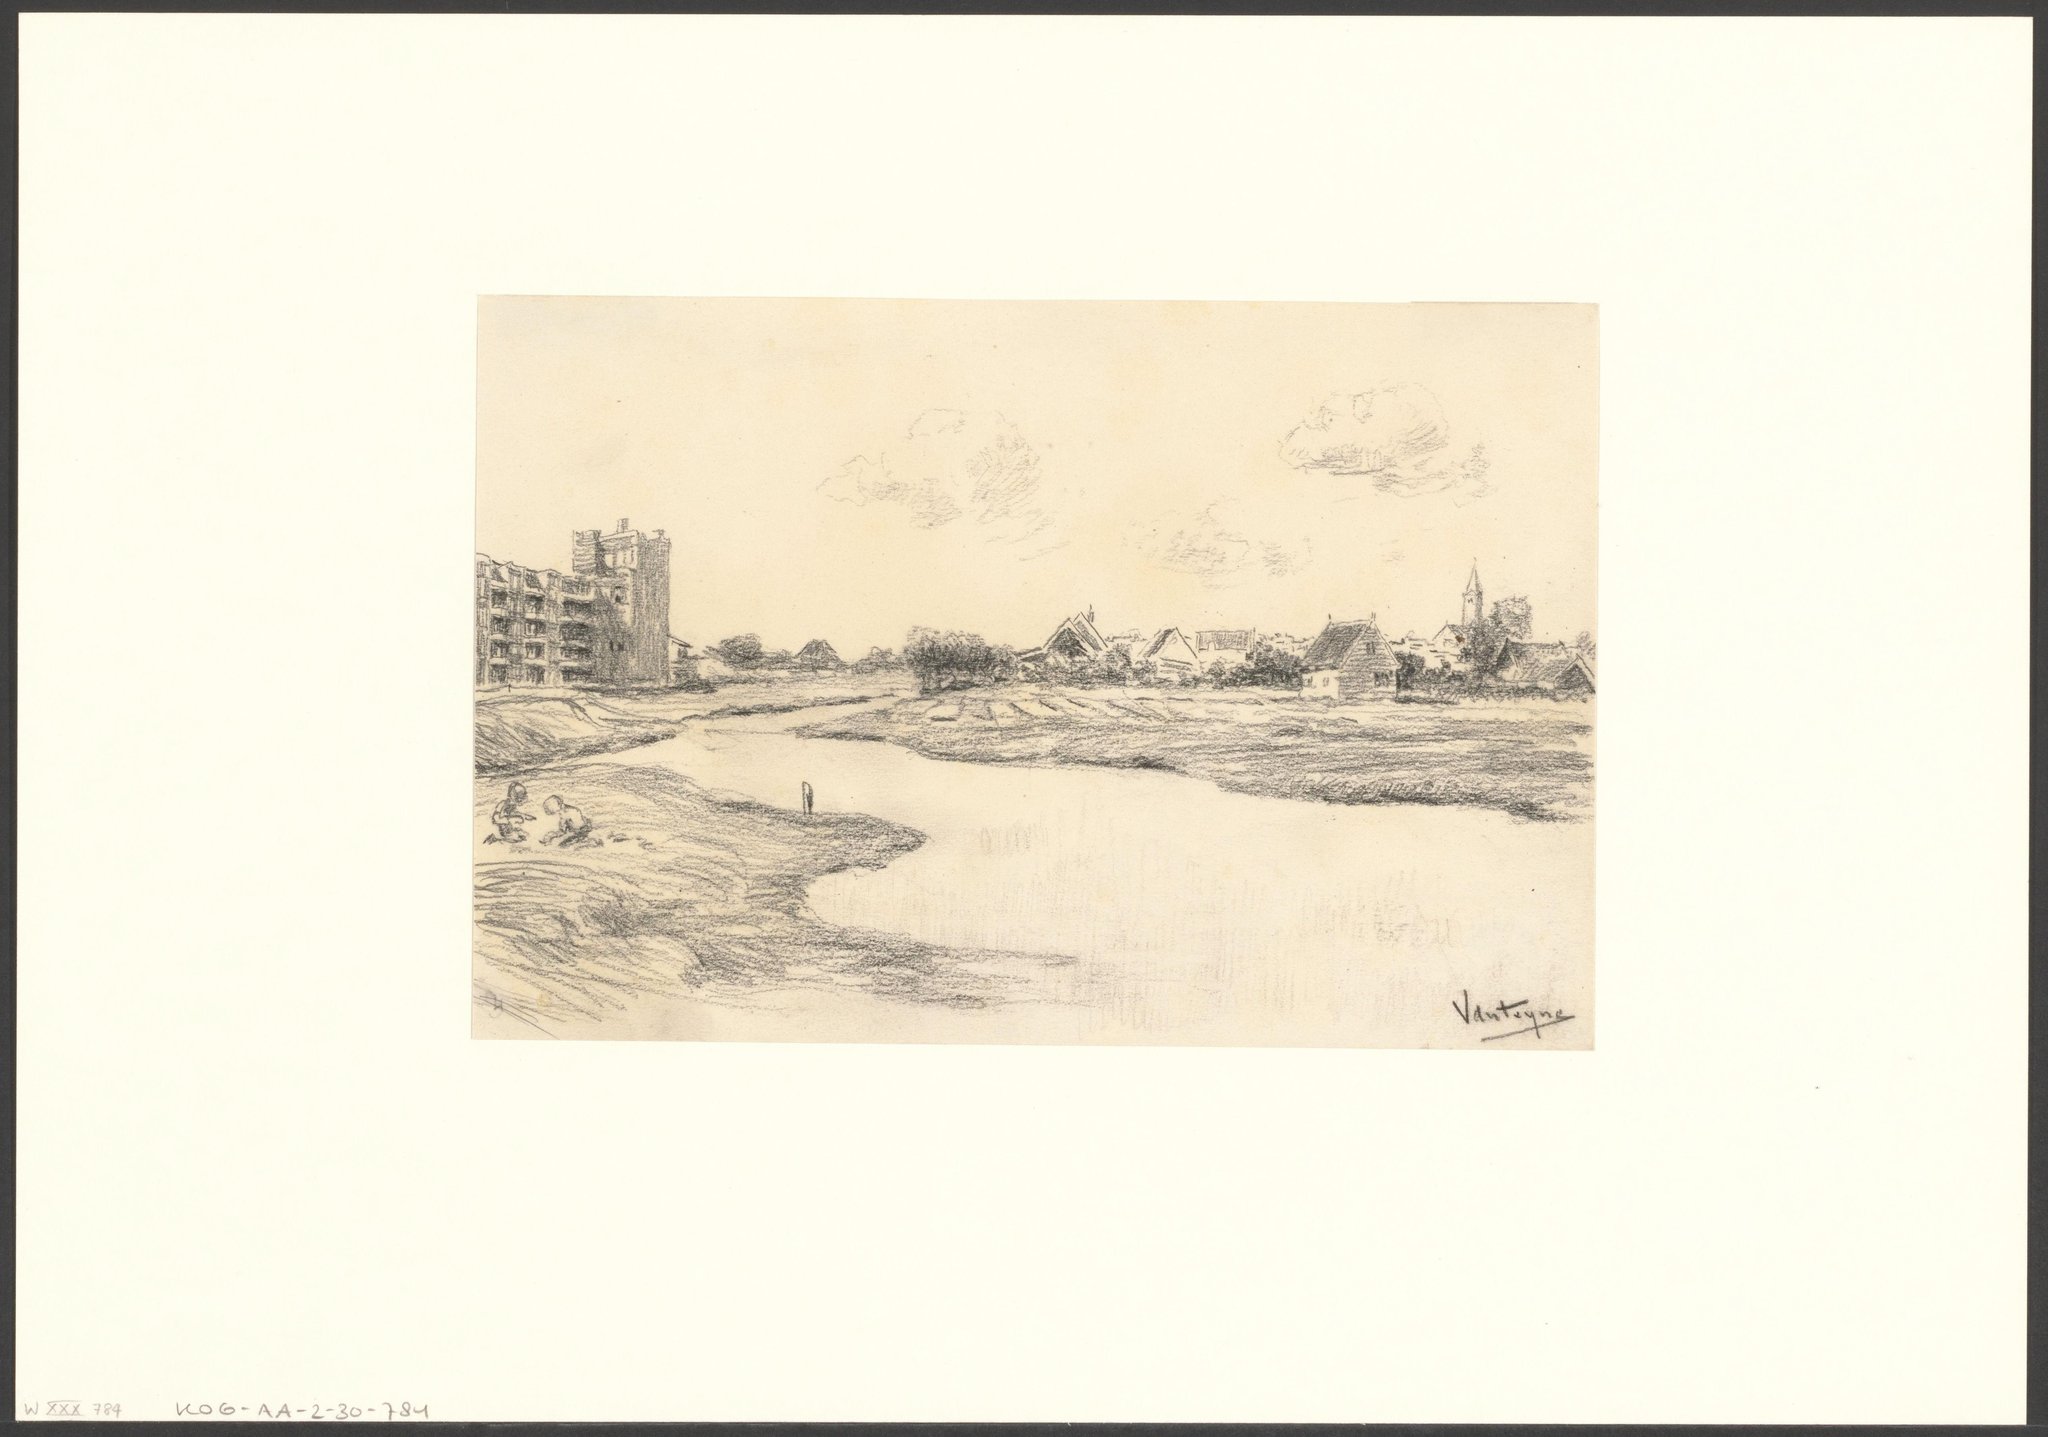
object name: drawing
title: Gezicht op de Warmoestuinen gezien vanaf de Jan van Galenstraat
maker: anthonie van teijn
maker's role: draughtsman, painter, print maker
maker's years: 1863-1943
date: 1927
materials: chalk, paper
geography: amsterdam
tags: city-view in general; 'veduta', canal, the usual house or row of houses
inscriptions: collector's mark: Lugt 800a, signature: ‘VanTeyne’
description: Tekening binnen de Atlas Van Eck ingedeeld op wijknummer 30.